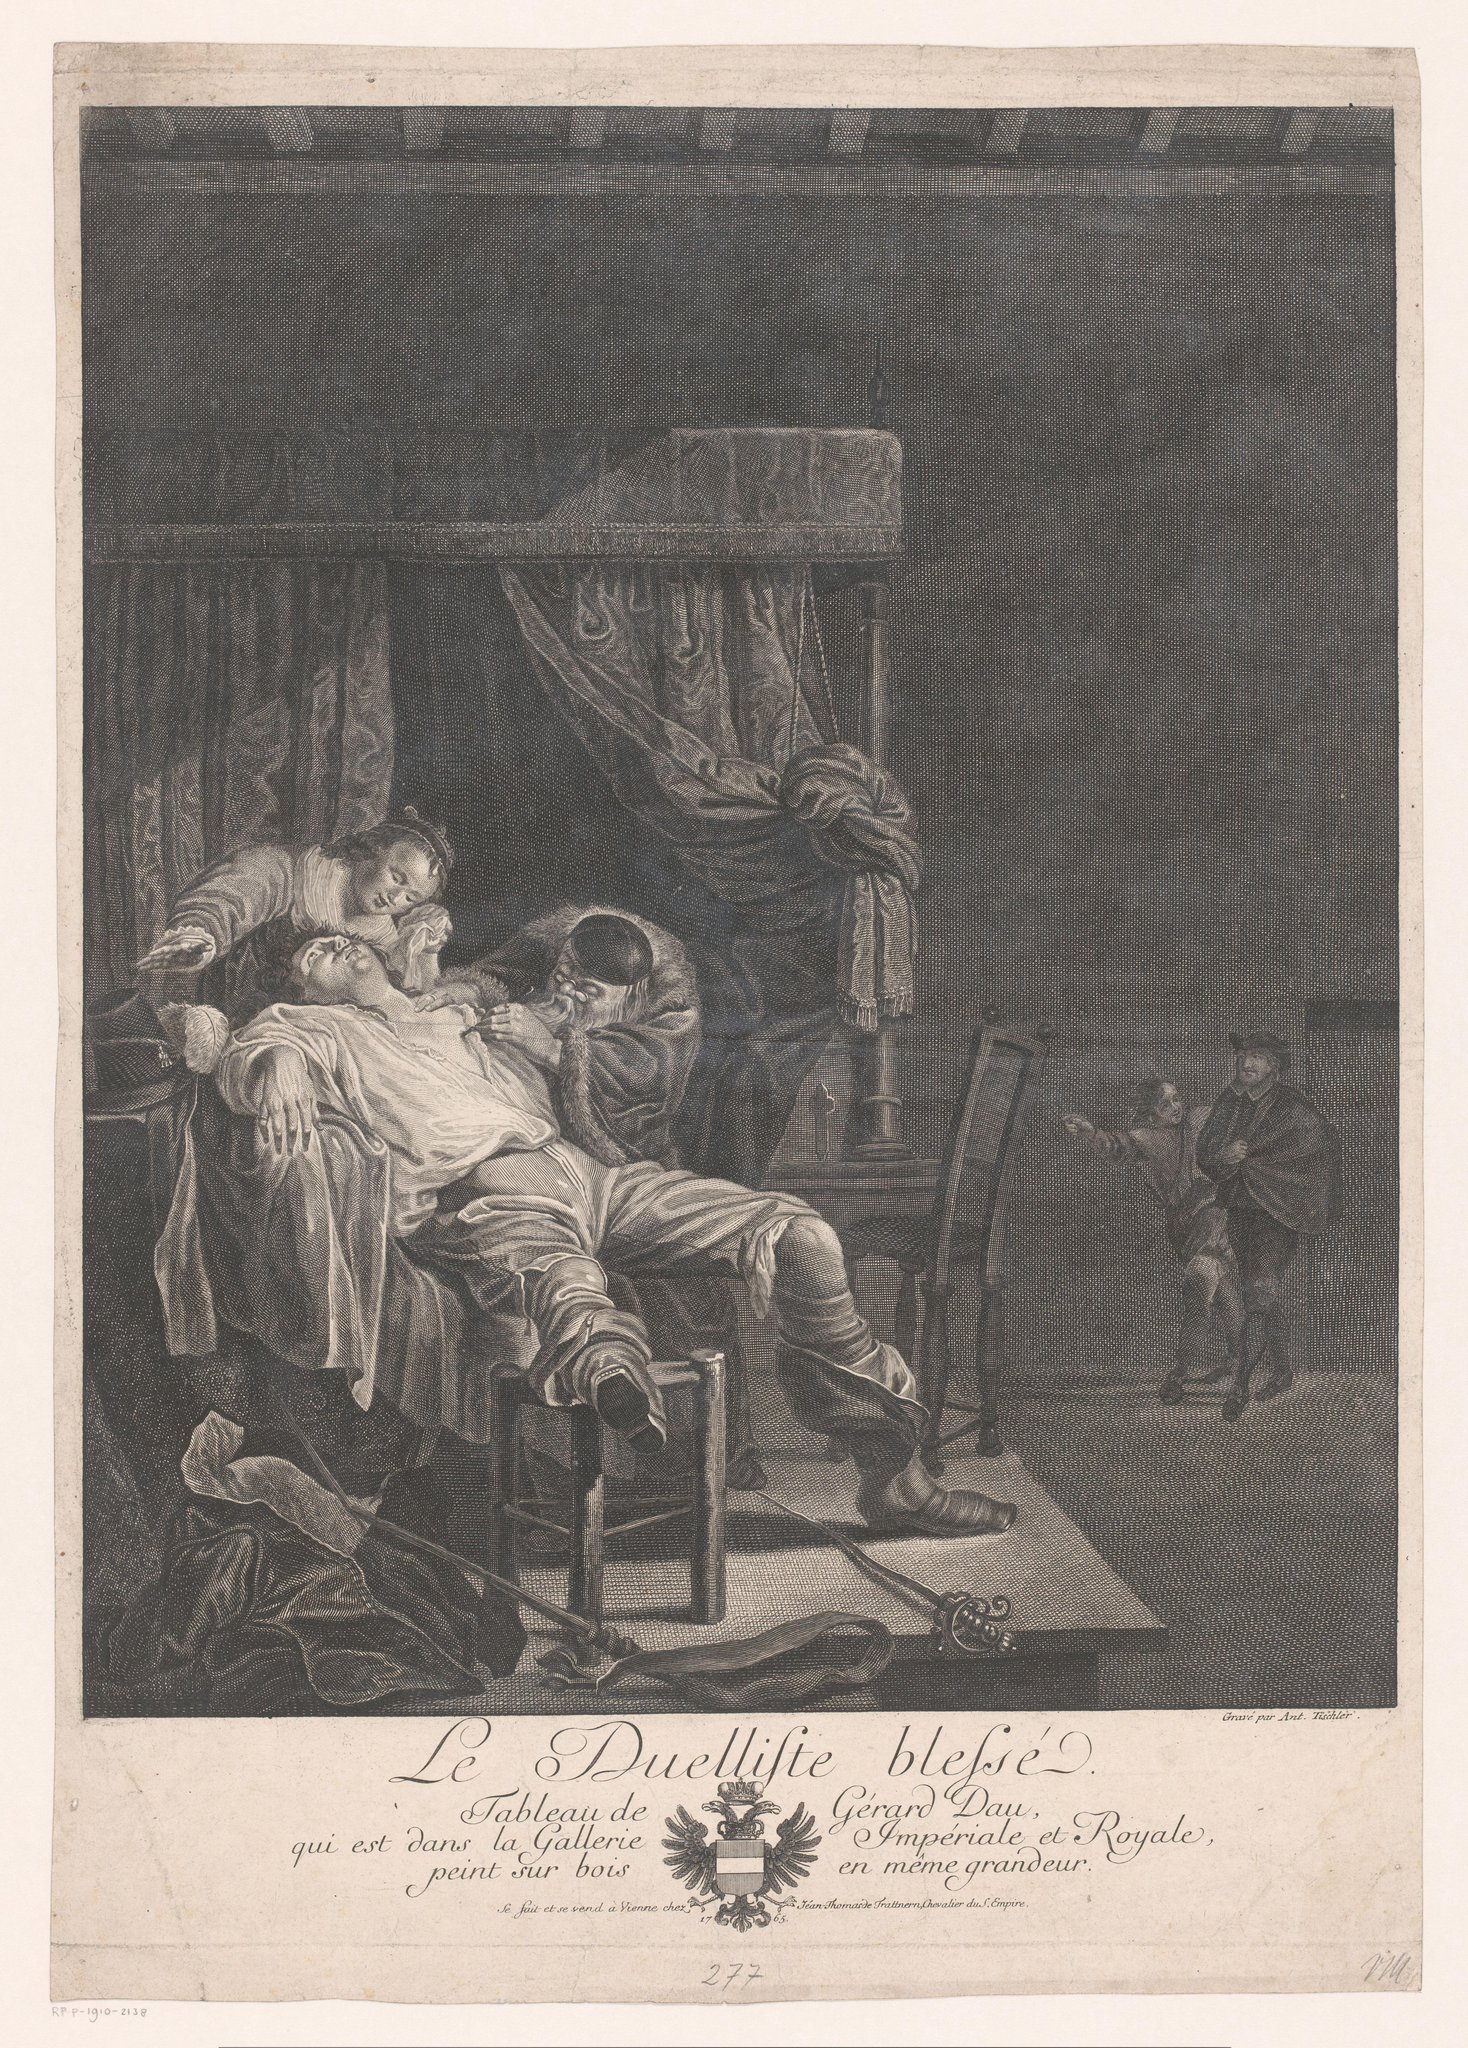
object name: print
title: Le Duelliste blessé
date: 1731-1780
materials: paper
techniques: engraving, etching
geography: vienna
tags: physician, doctor, armorial bearing, heraldry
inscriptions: collector's mark: Lugt 2228